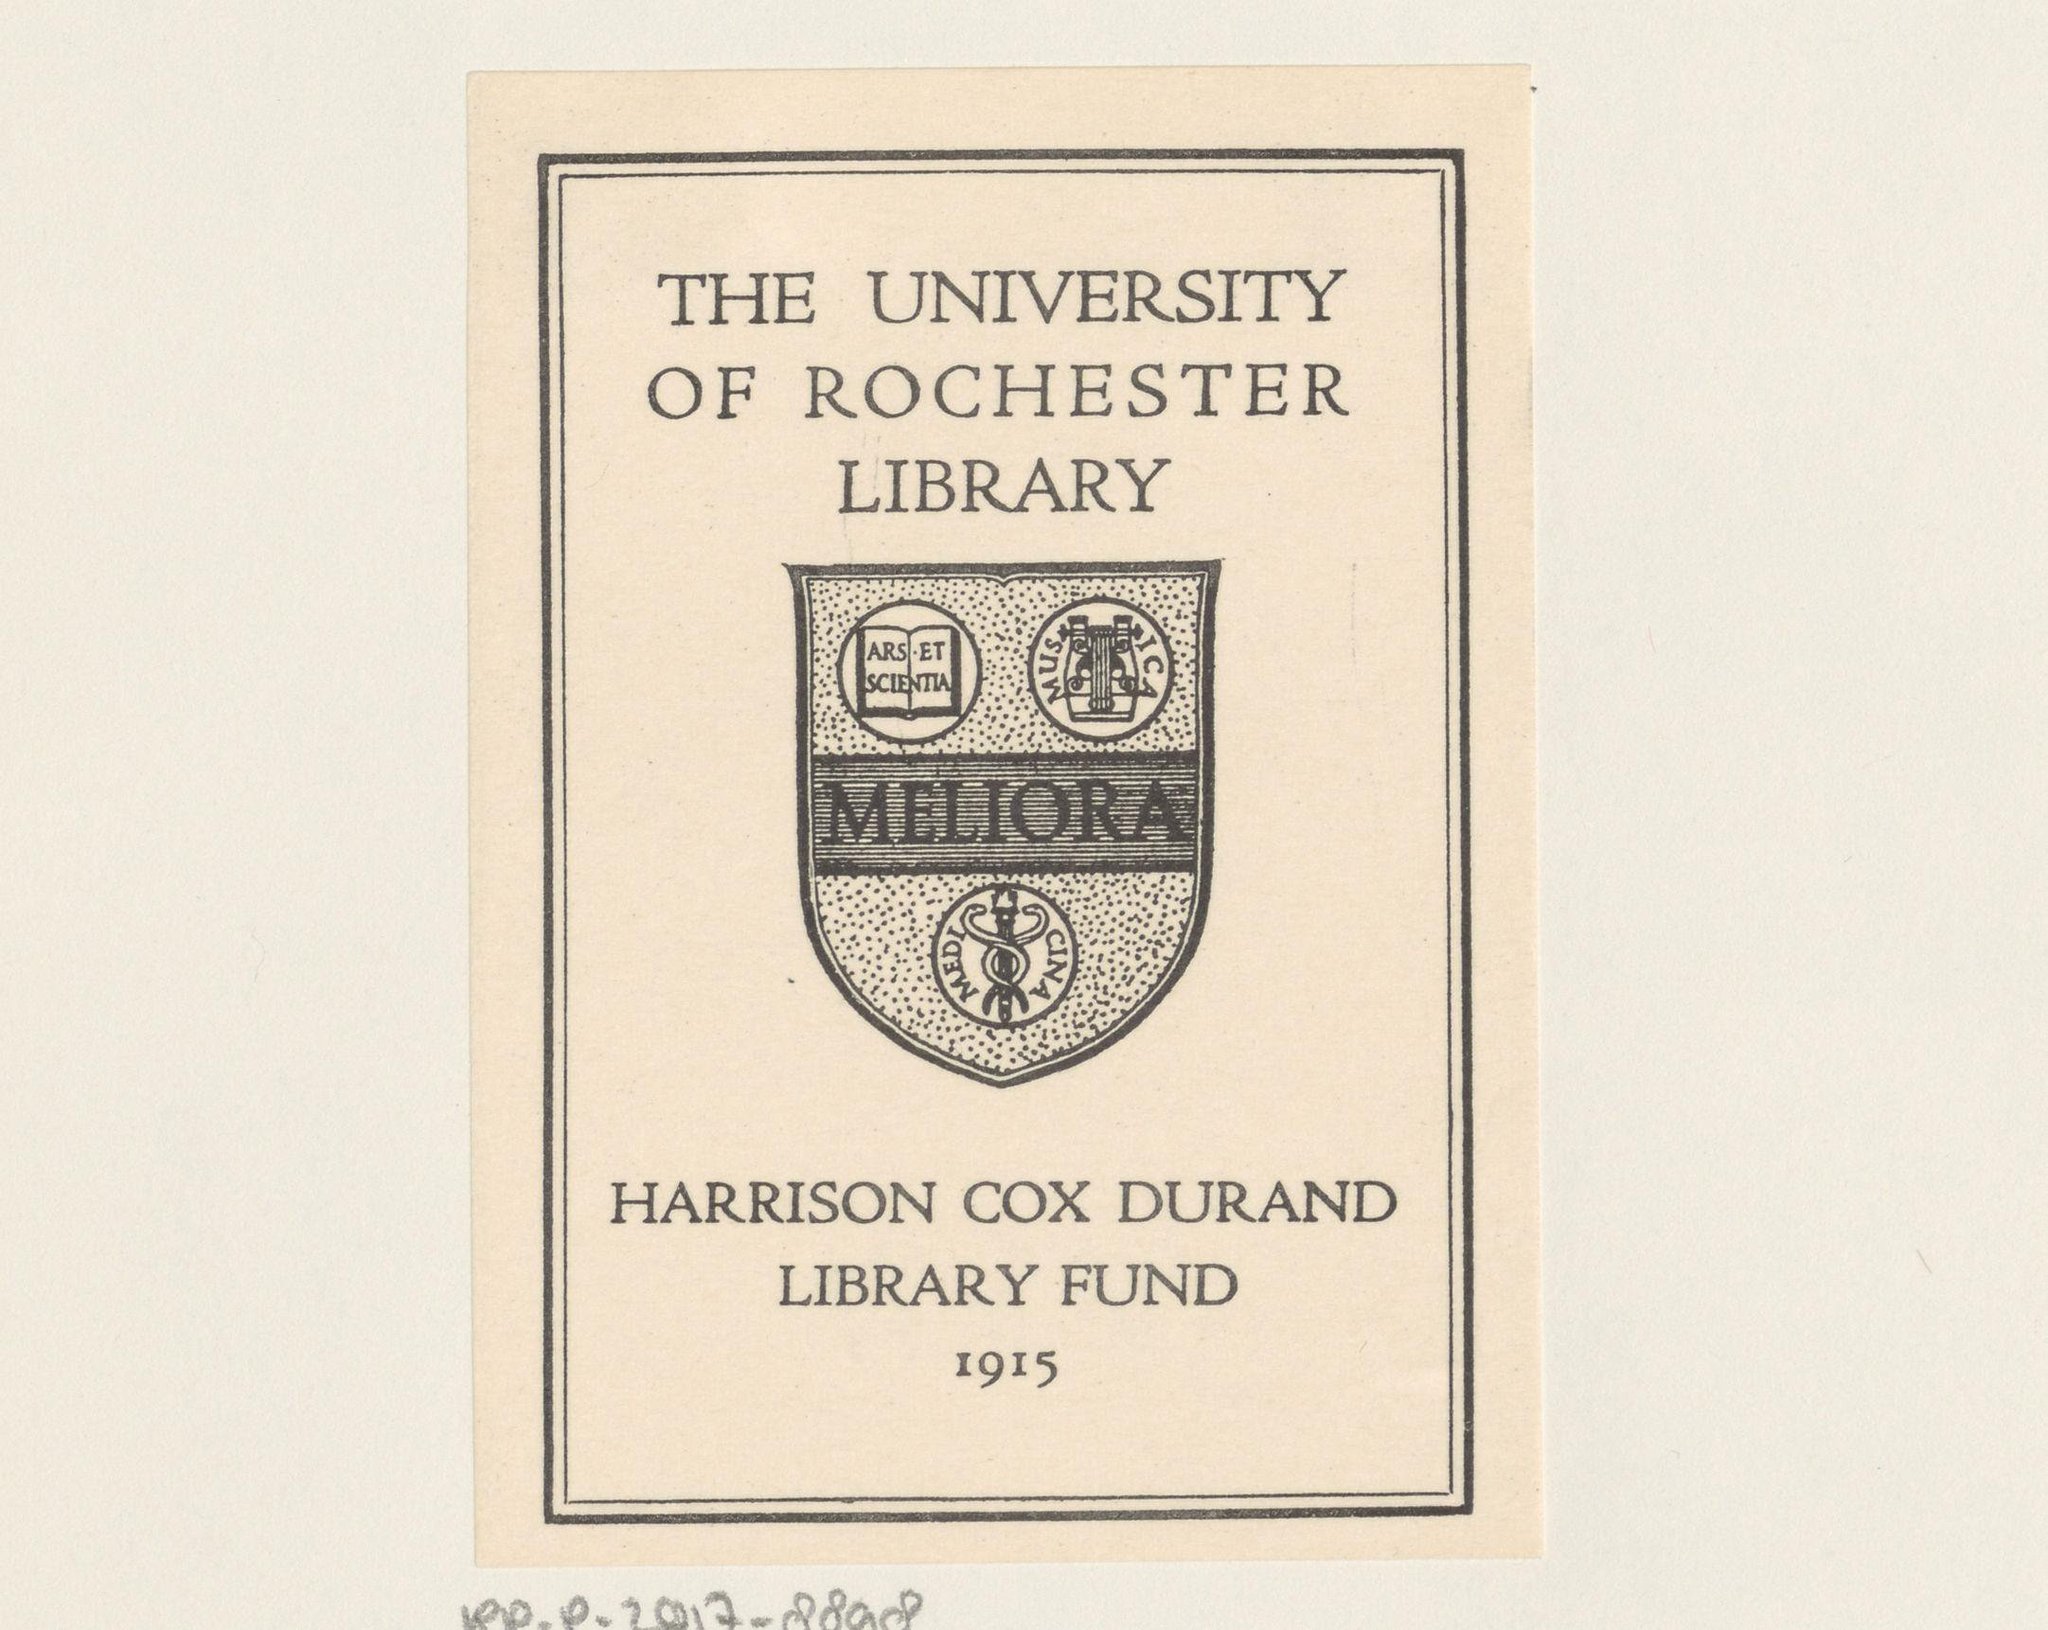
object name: bookplate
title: Ex libris van de University of Rochester Library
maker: Anonymous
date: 1915-1999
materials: paper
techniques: printing block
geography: north and central america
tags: armorial bearing, heraldry